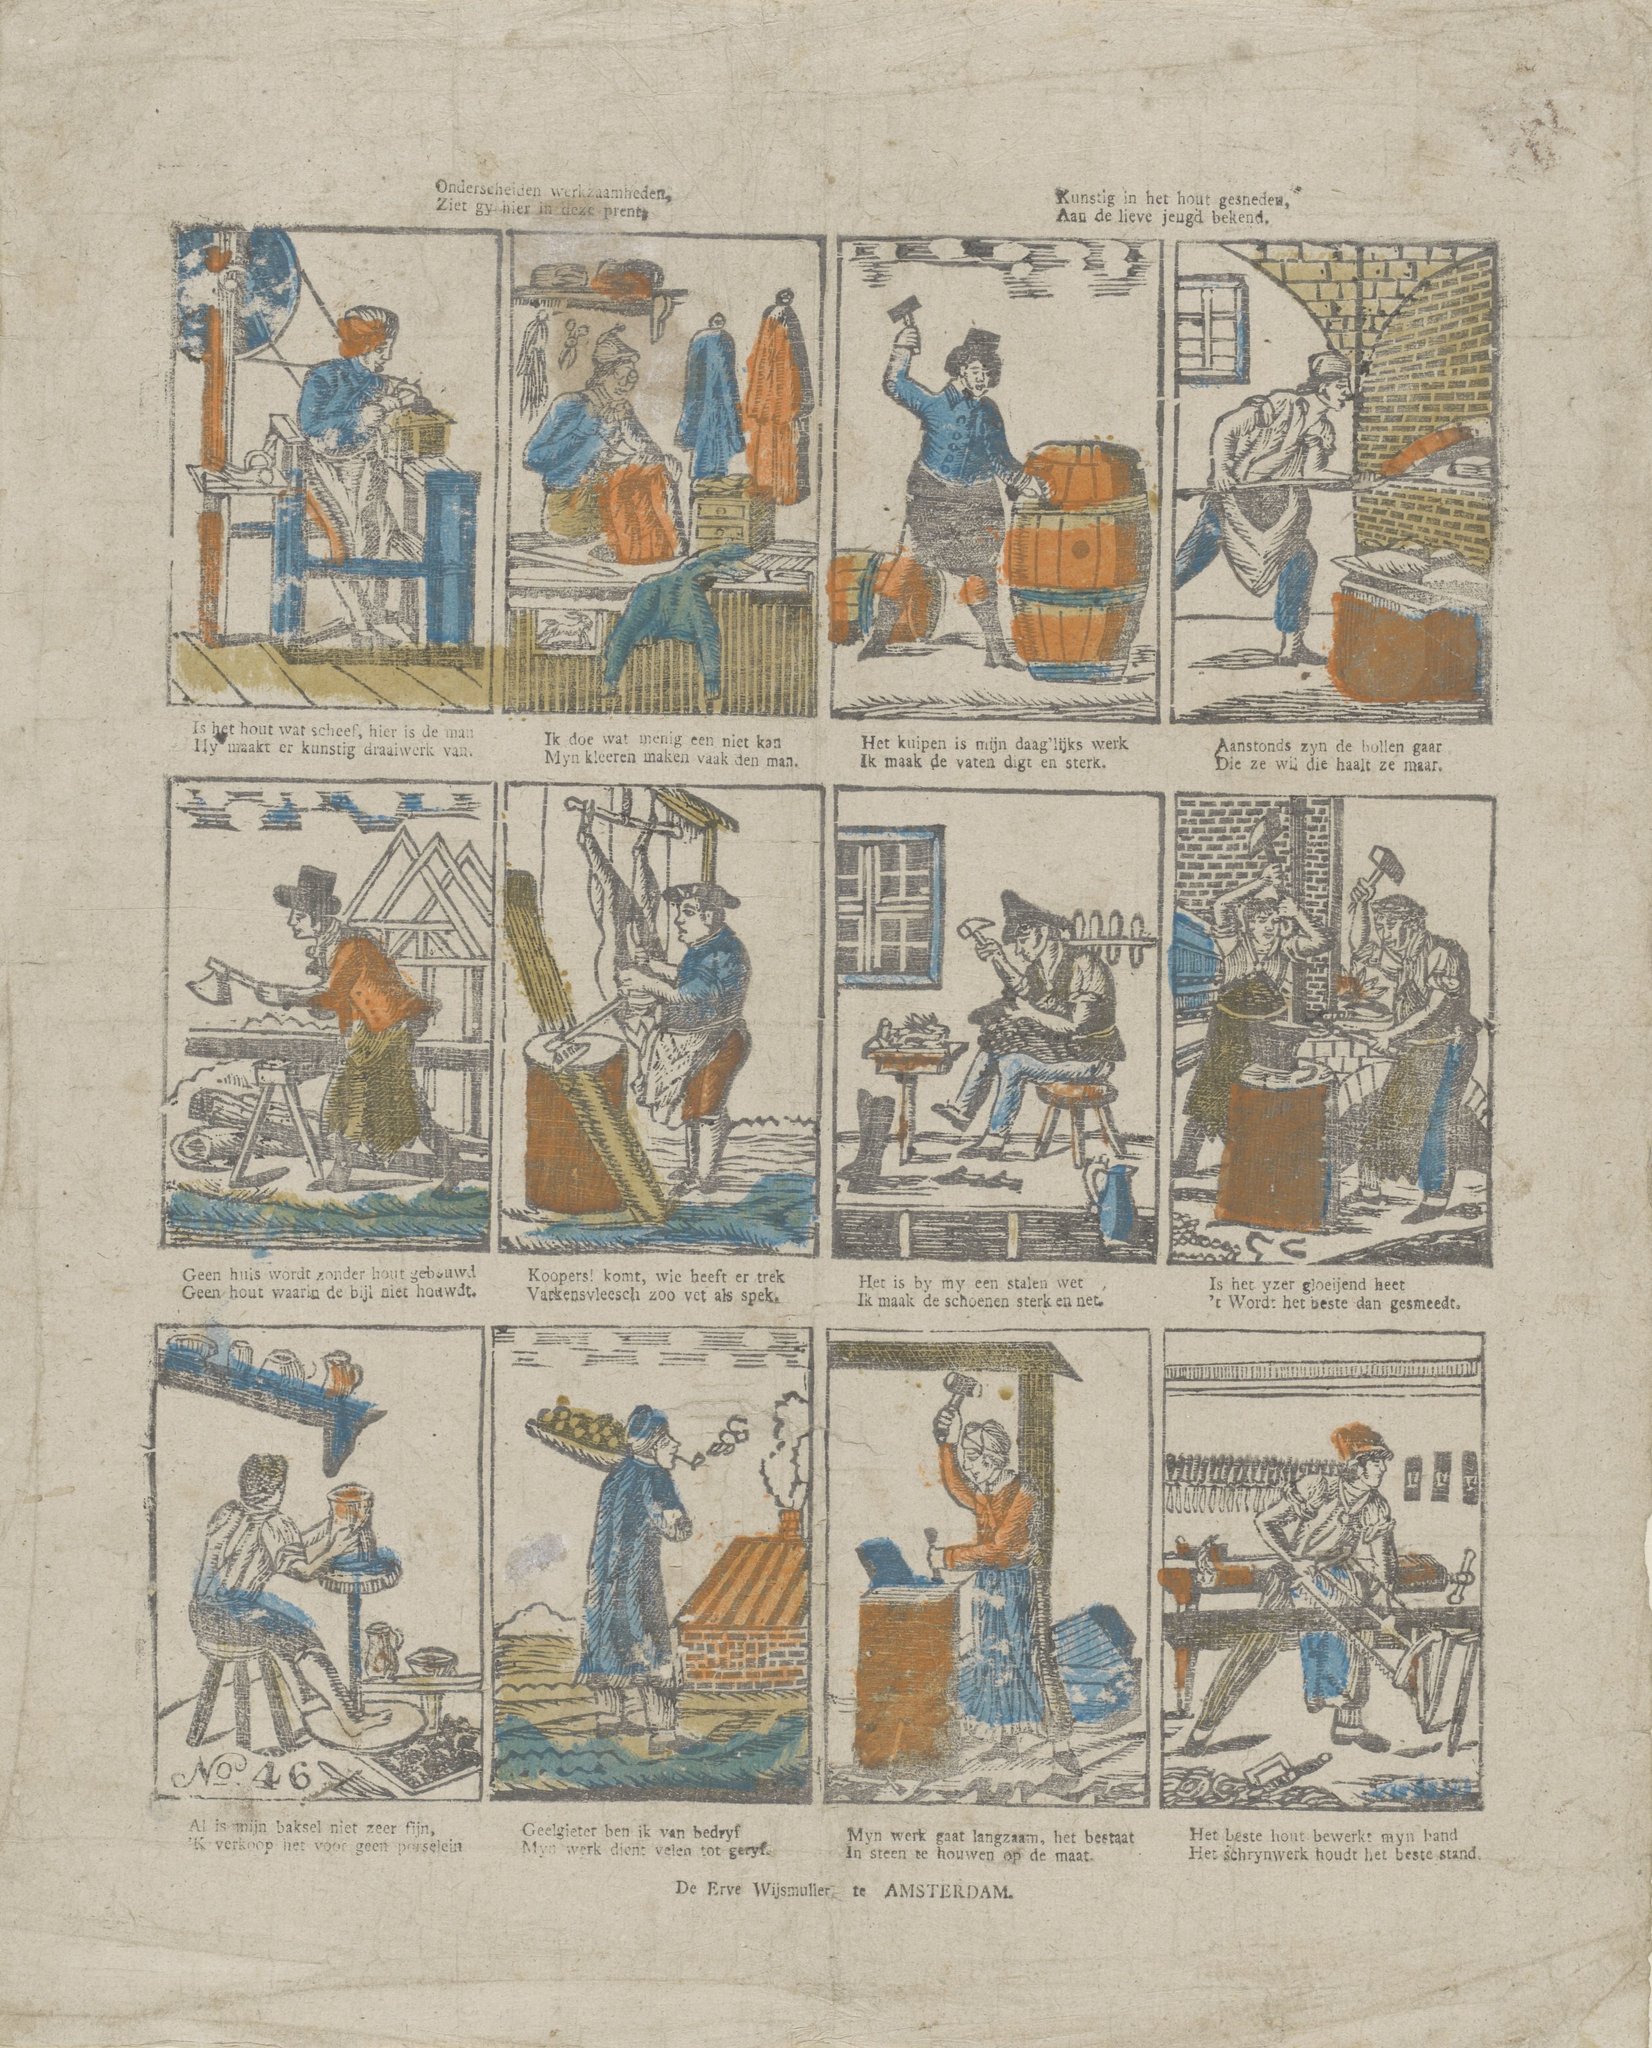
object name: print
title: Onderscheiden werkzaamheden, / Ziet gy hier in deze prent, / Kunstig in het hout gesneden, / Aan de lieve jeugd bekend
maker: Anonymous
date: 1828-1913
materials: paper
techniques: colour, letterpress printing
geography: netherlands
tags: carpenter, craft-production, skilled handiwork, butcher, slaughterman, tailor, dressmaker, crafts and industries, potter, ceramist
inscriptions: collector's mark: Lugt 2760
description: Blad met 12 voorstellingen van ambachtslieden en beroepen, zoals kleermaker, kuiper en slager. Onder elke afbeelding een tweeregelig vers. Genummerd linksonder: no. 46.